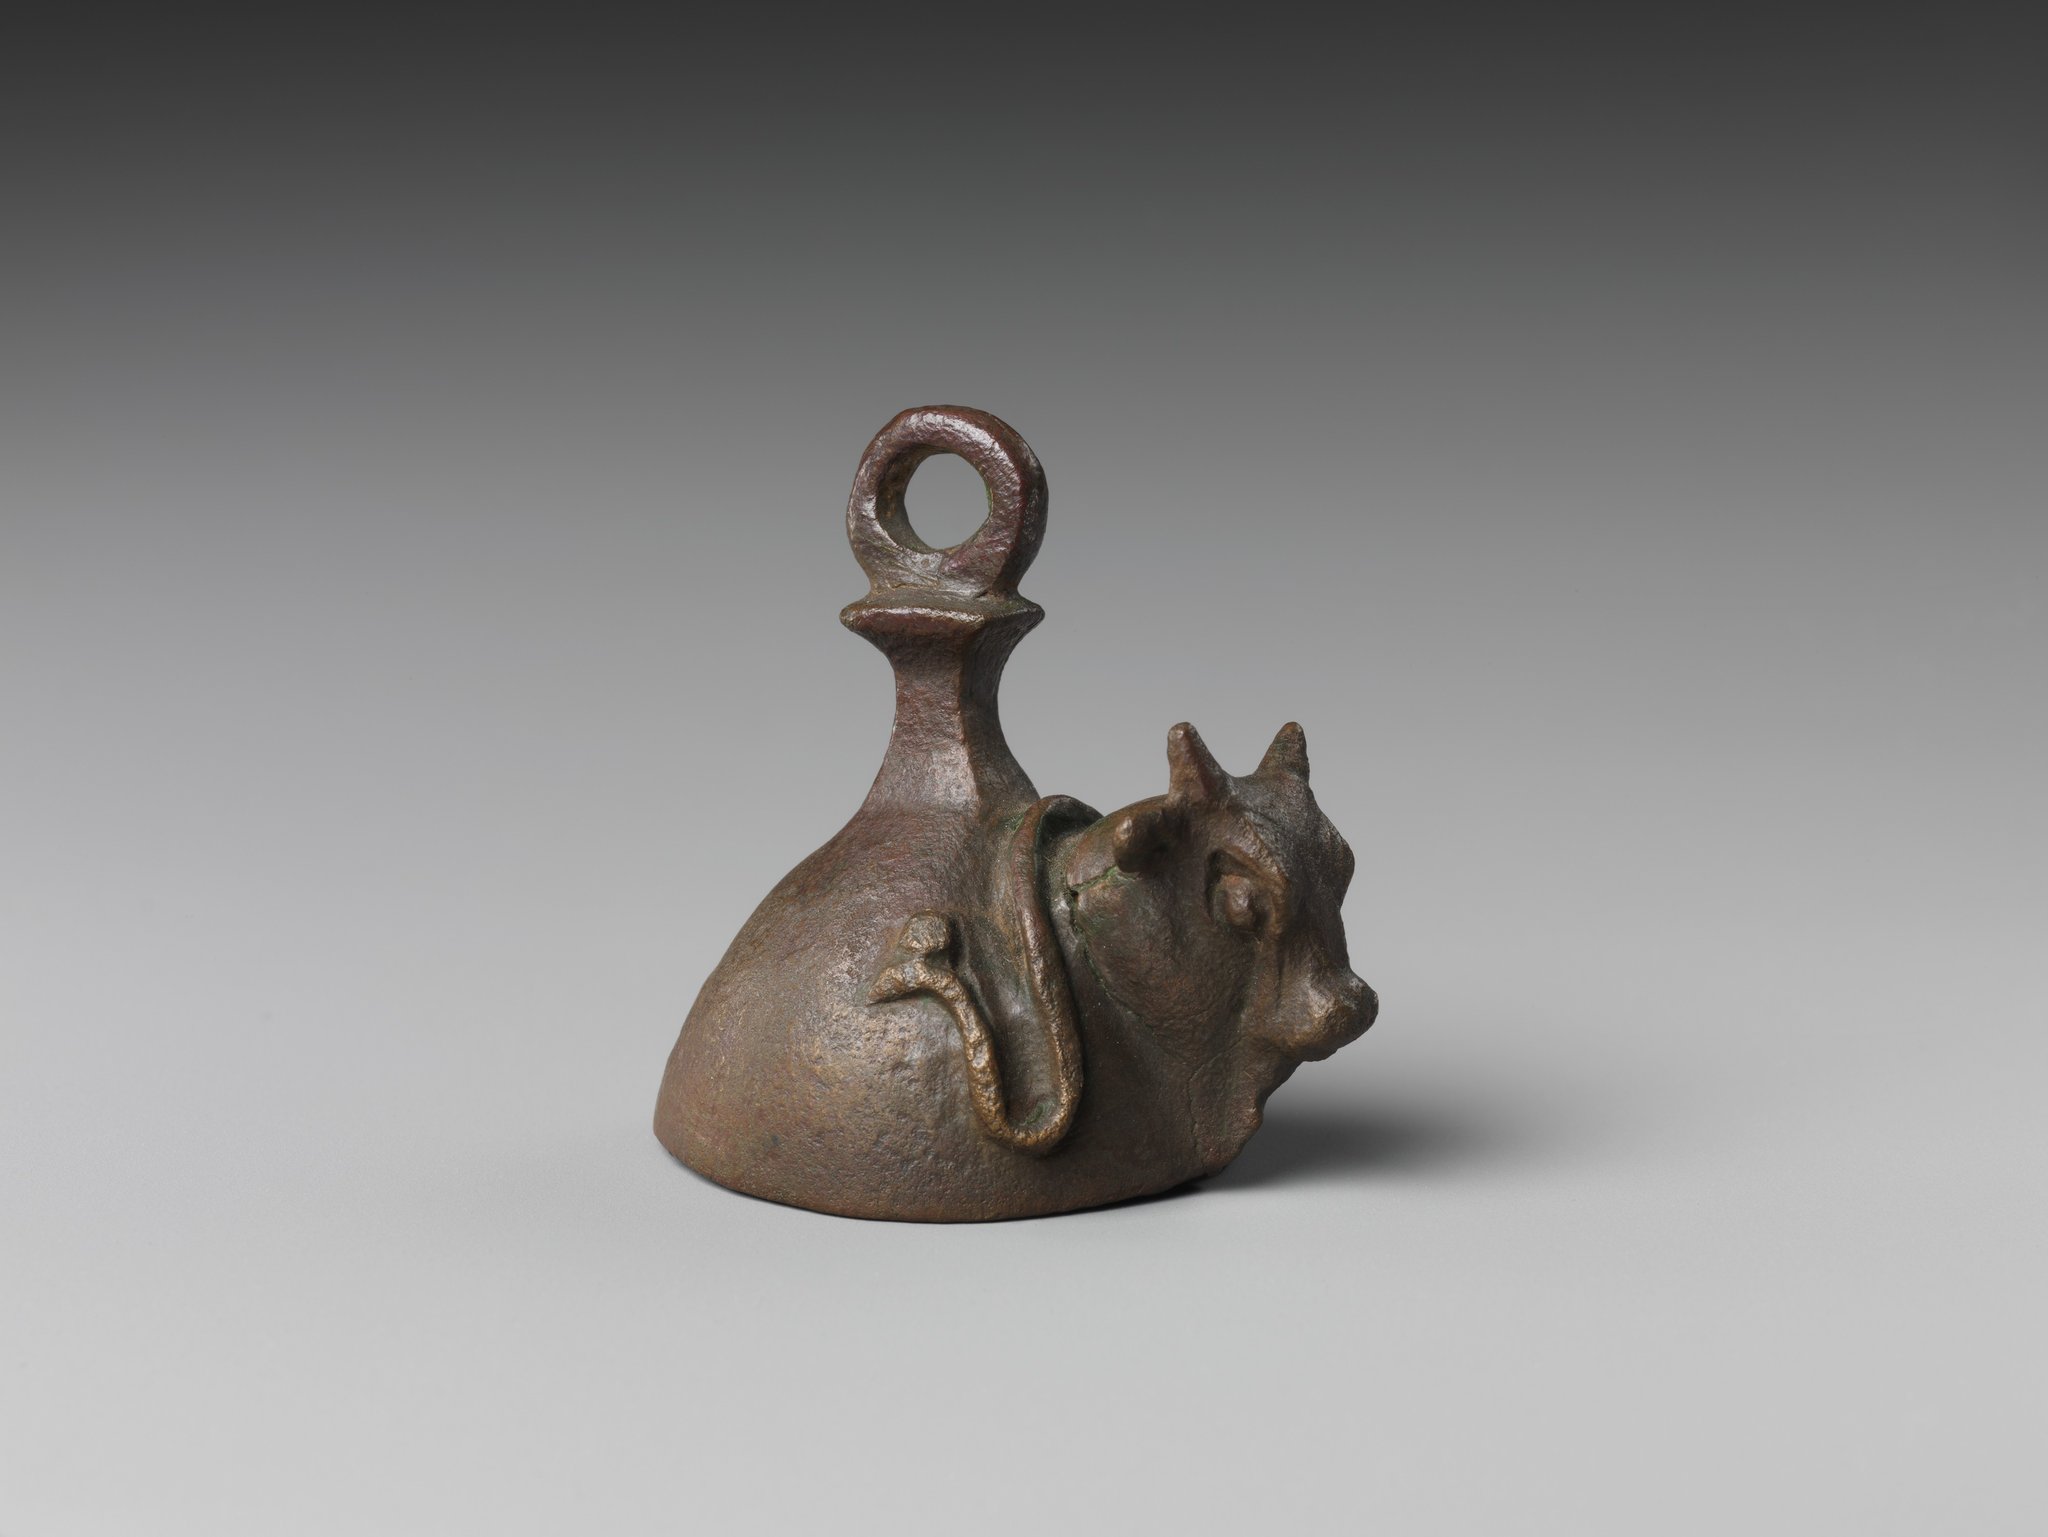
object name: music, bell, bovine head, uraeus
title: Bell with head of a bovine wearing a yoke ending in uraei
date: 332-330 BCE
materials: bronze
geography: egypt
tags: animals